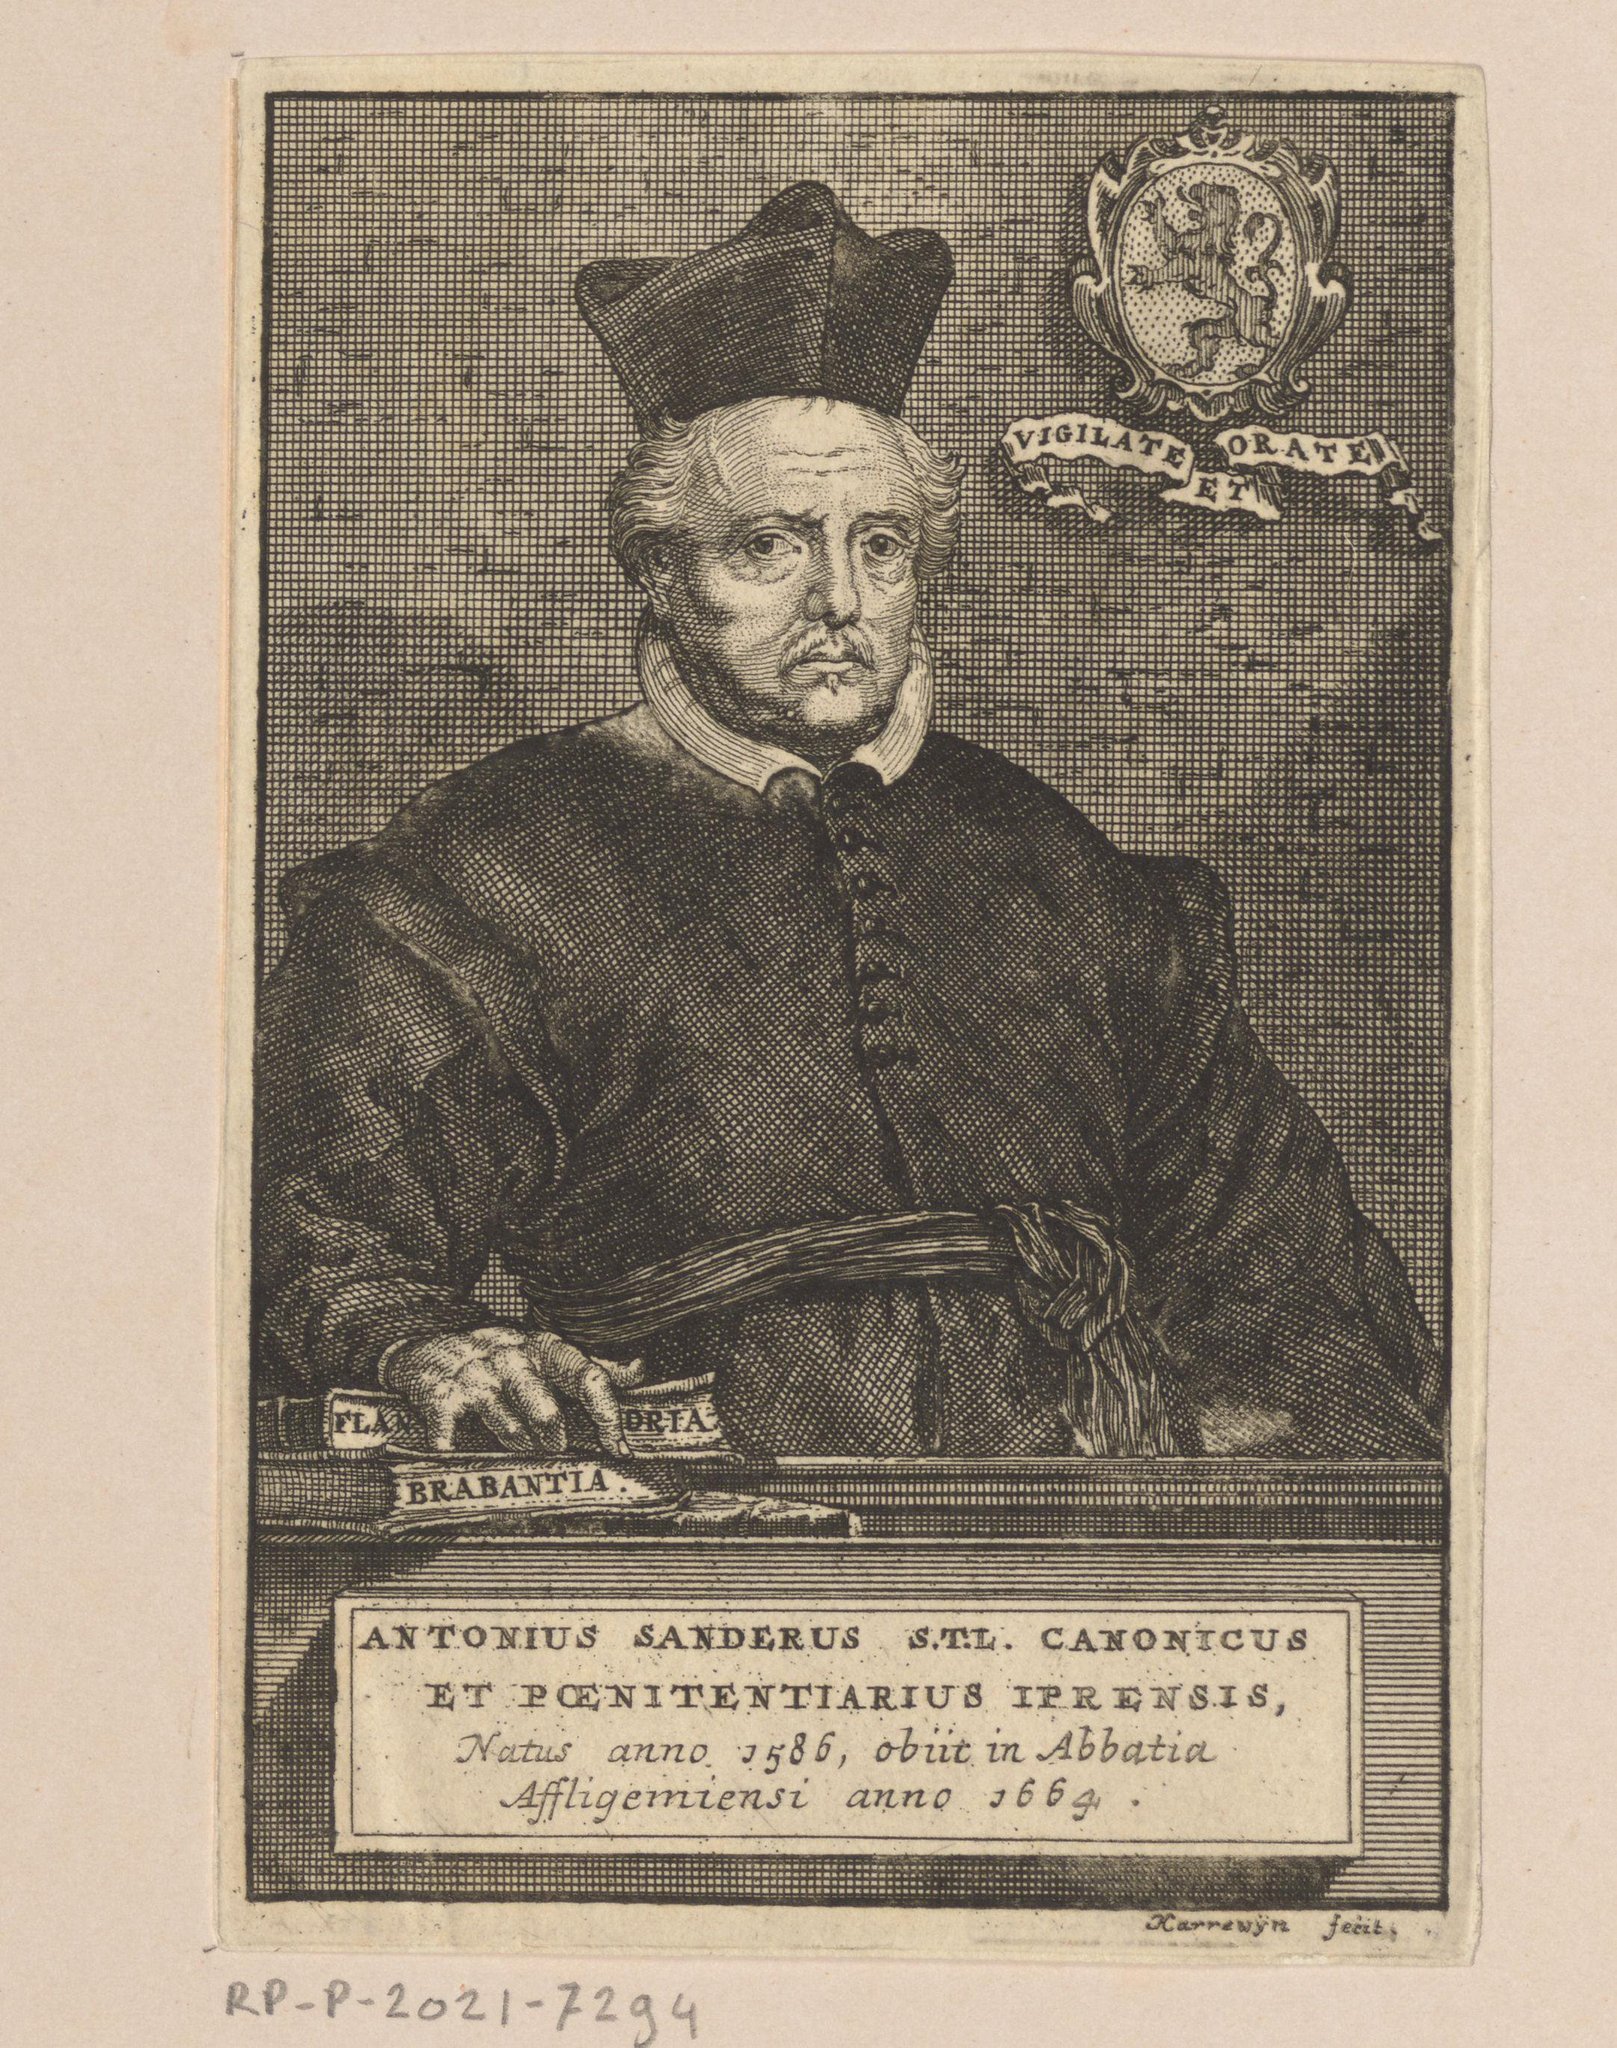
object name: print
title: Portret van Antonius Sanderus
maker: jacobus harrewijn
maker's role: print maker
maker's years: 1660-1740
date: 1682-1732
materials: paper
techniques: etching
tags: antonius sanderus, scholar, philosopher, historical persons, armorial bearing, heraldry